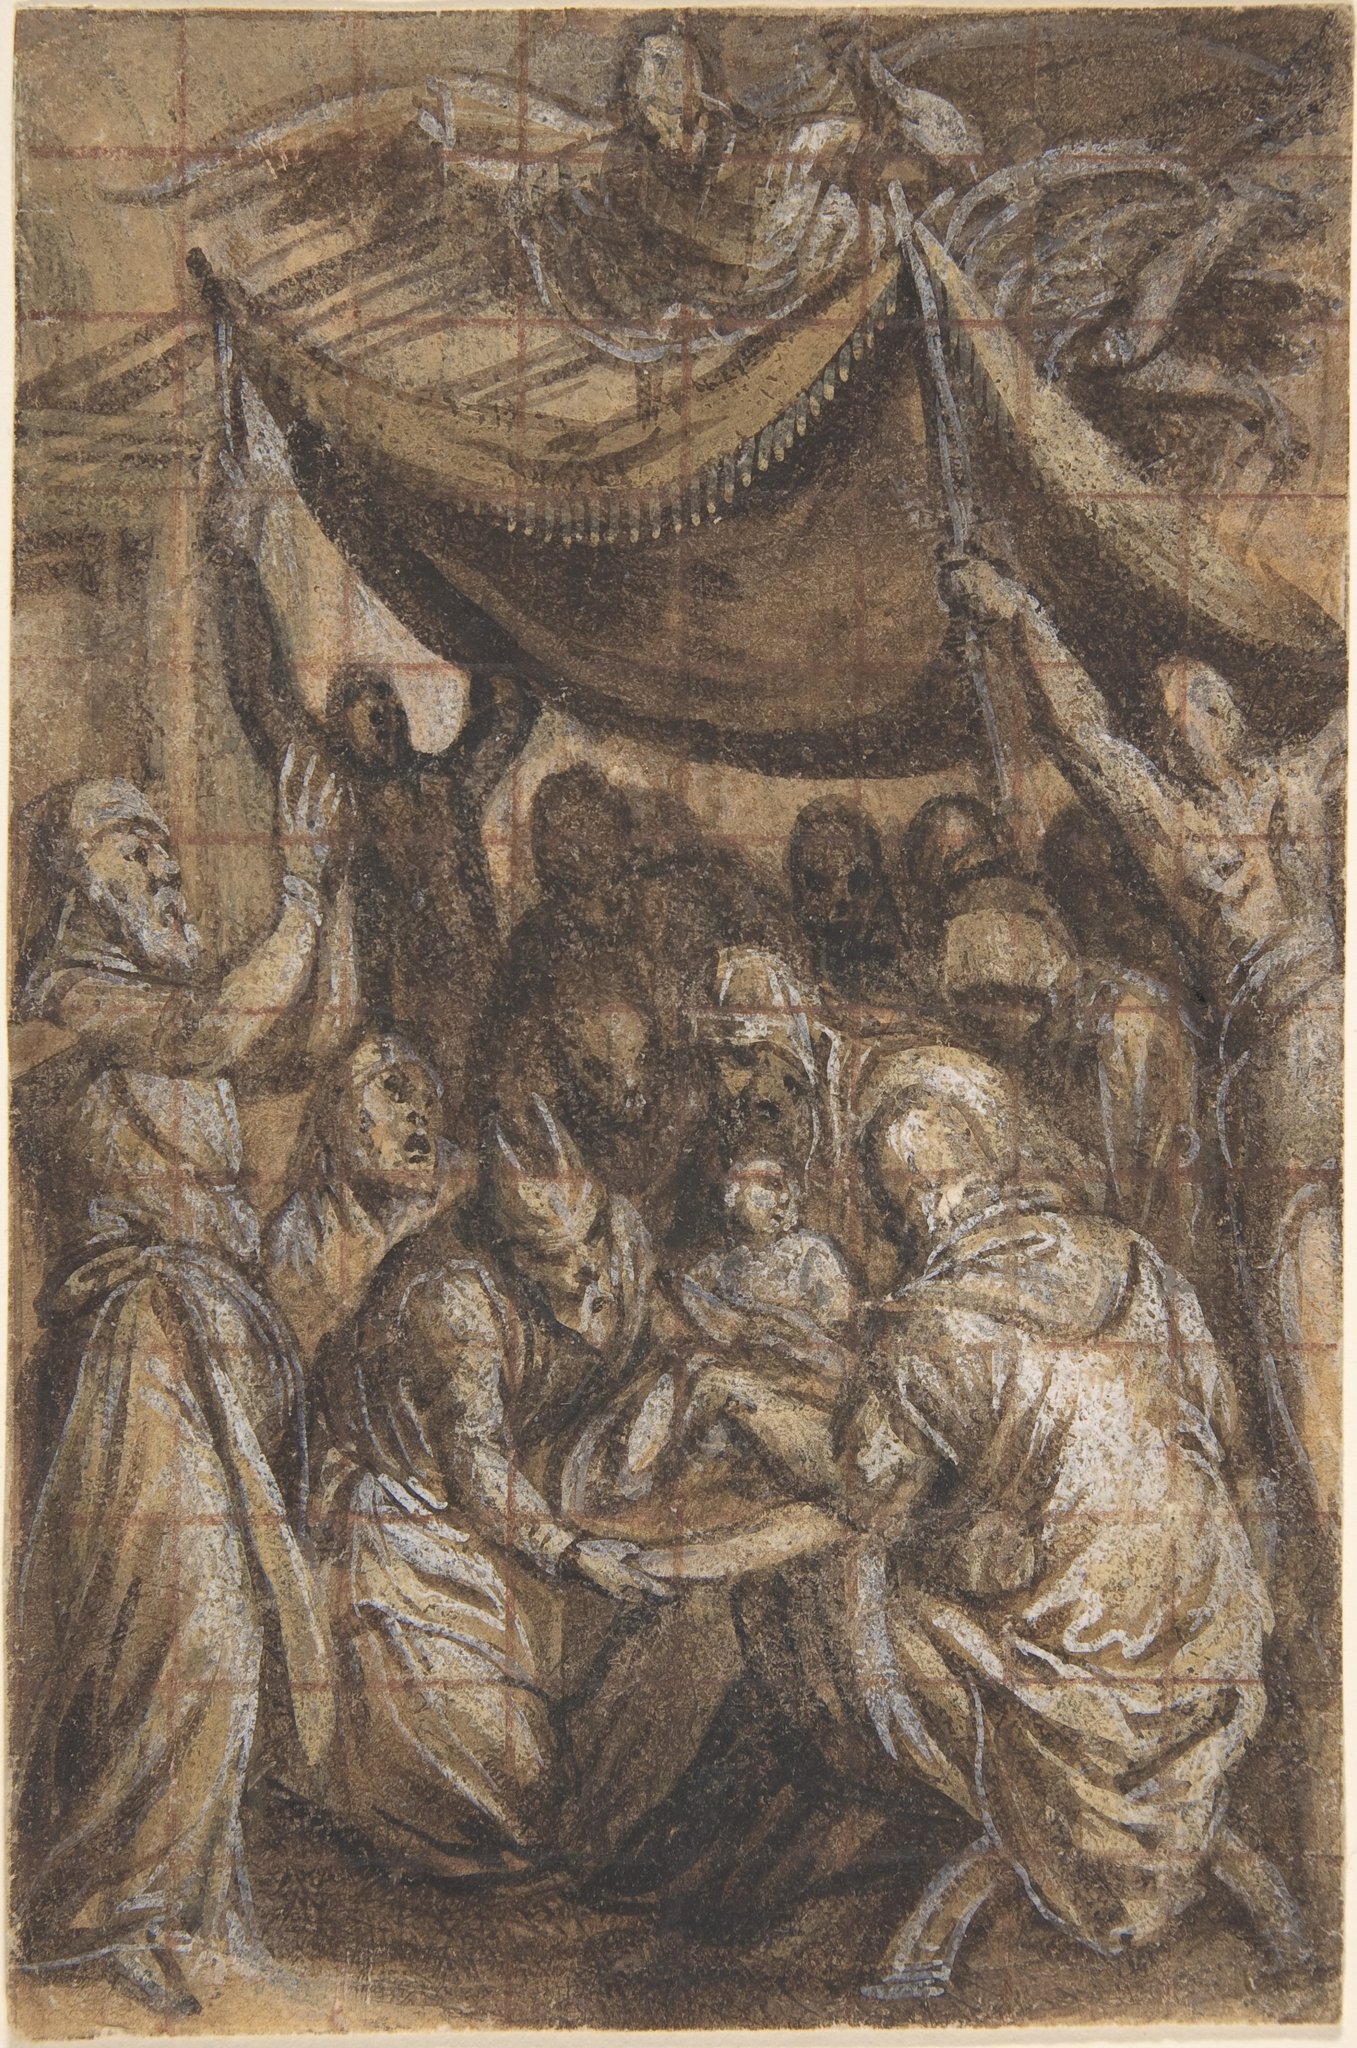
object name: drawing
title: The Circumcision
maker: hans mielich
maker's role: artist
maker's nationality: german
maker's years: 1516-1573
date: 1516-1573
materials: paint, ink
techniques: brush, wash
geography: germany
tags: men,jesus,circumcision